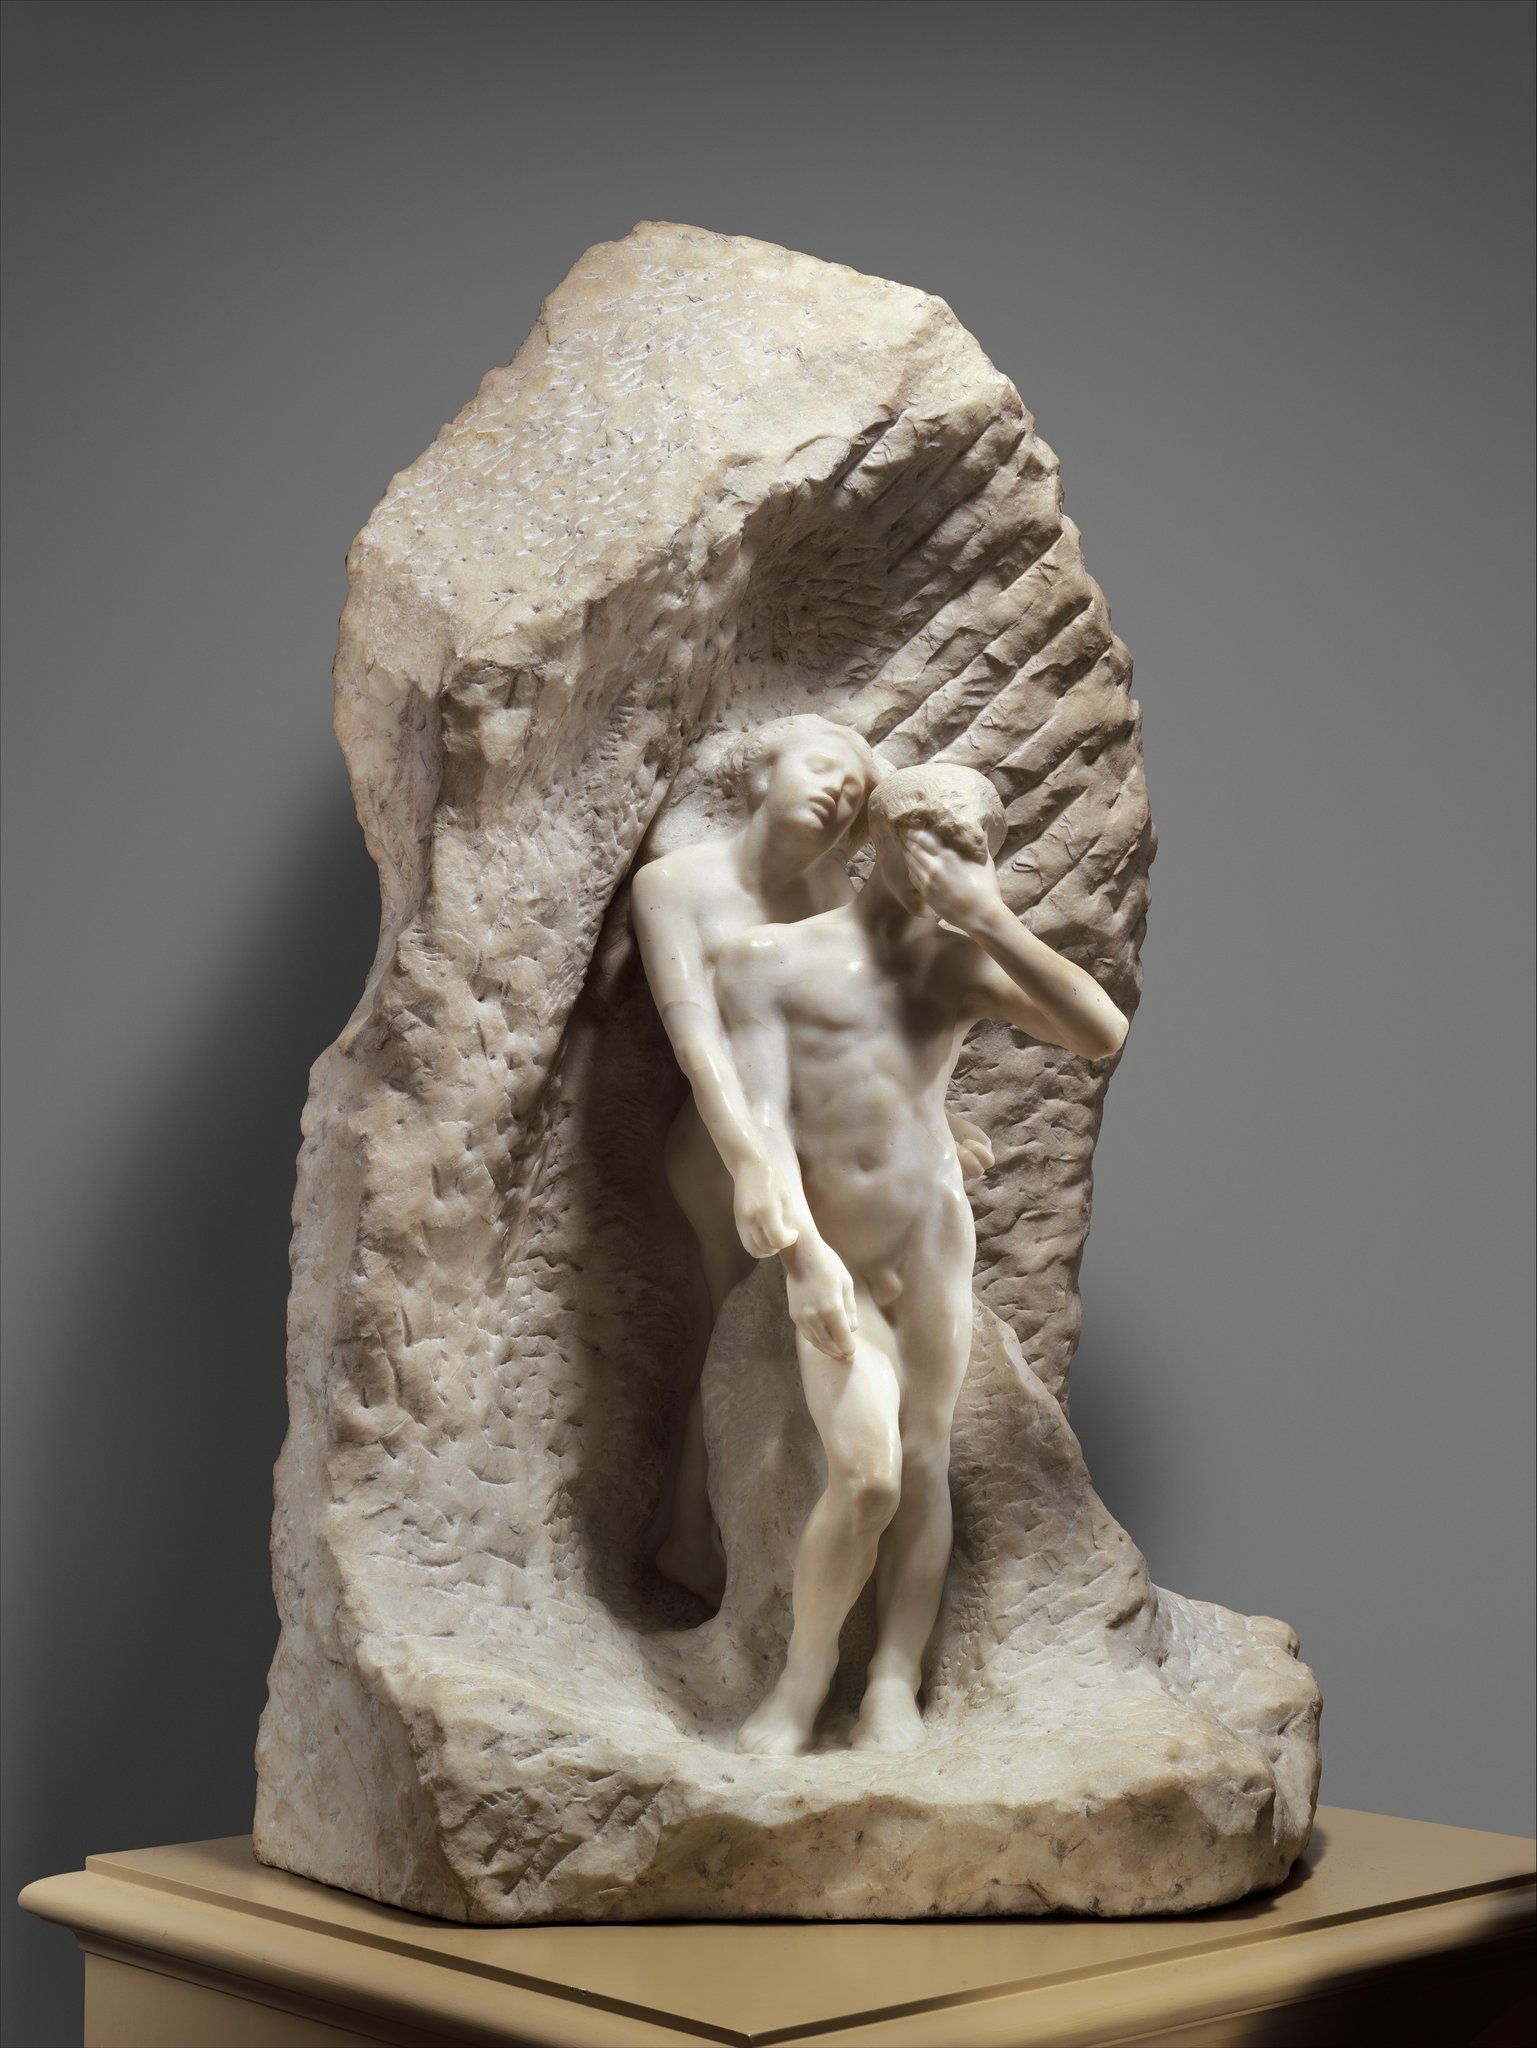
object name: group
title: Orpheus and Eurydice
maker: auguste rodin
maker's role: artist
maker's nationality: french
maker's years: 1840-1917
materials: marble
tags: male nudes,female nudes,orpheus,eurydice